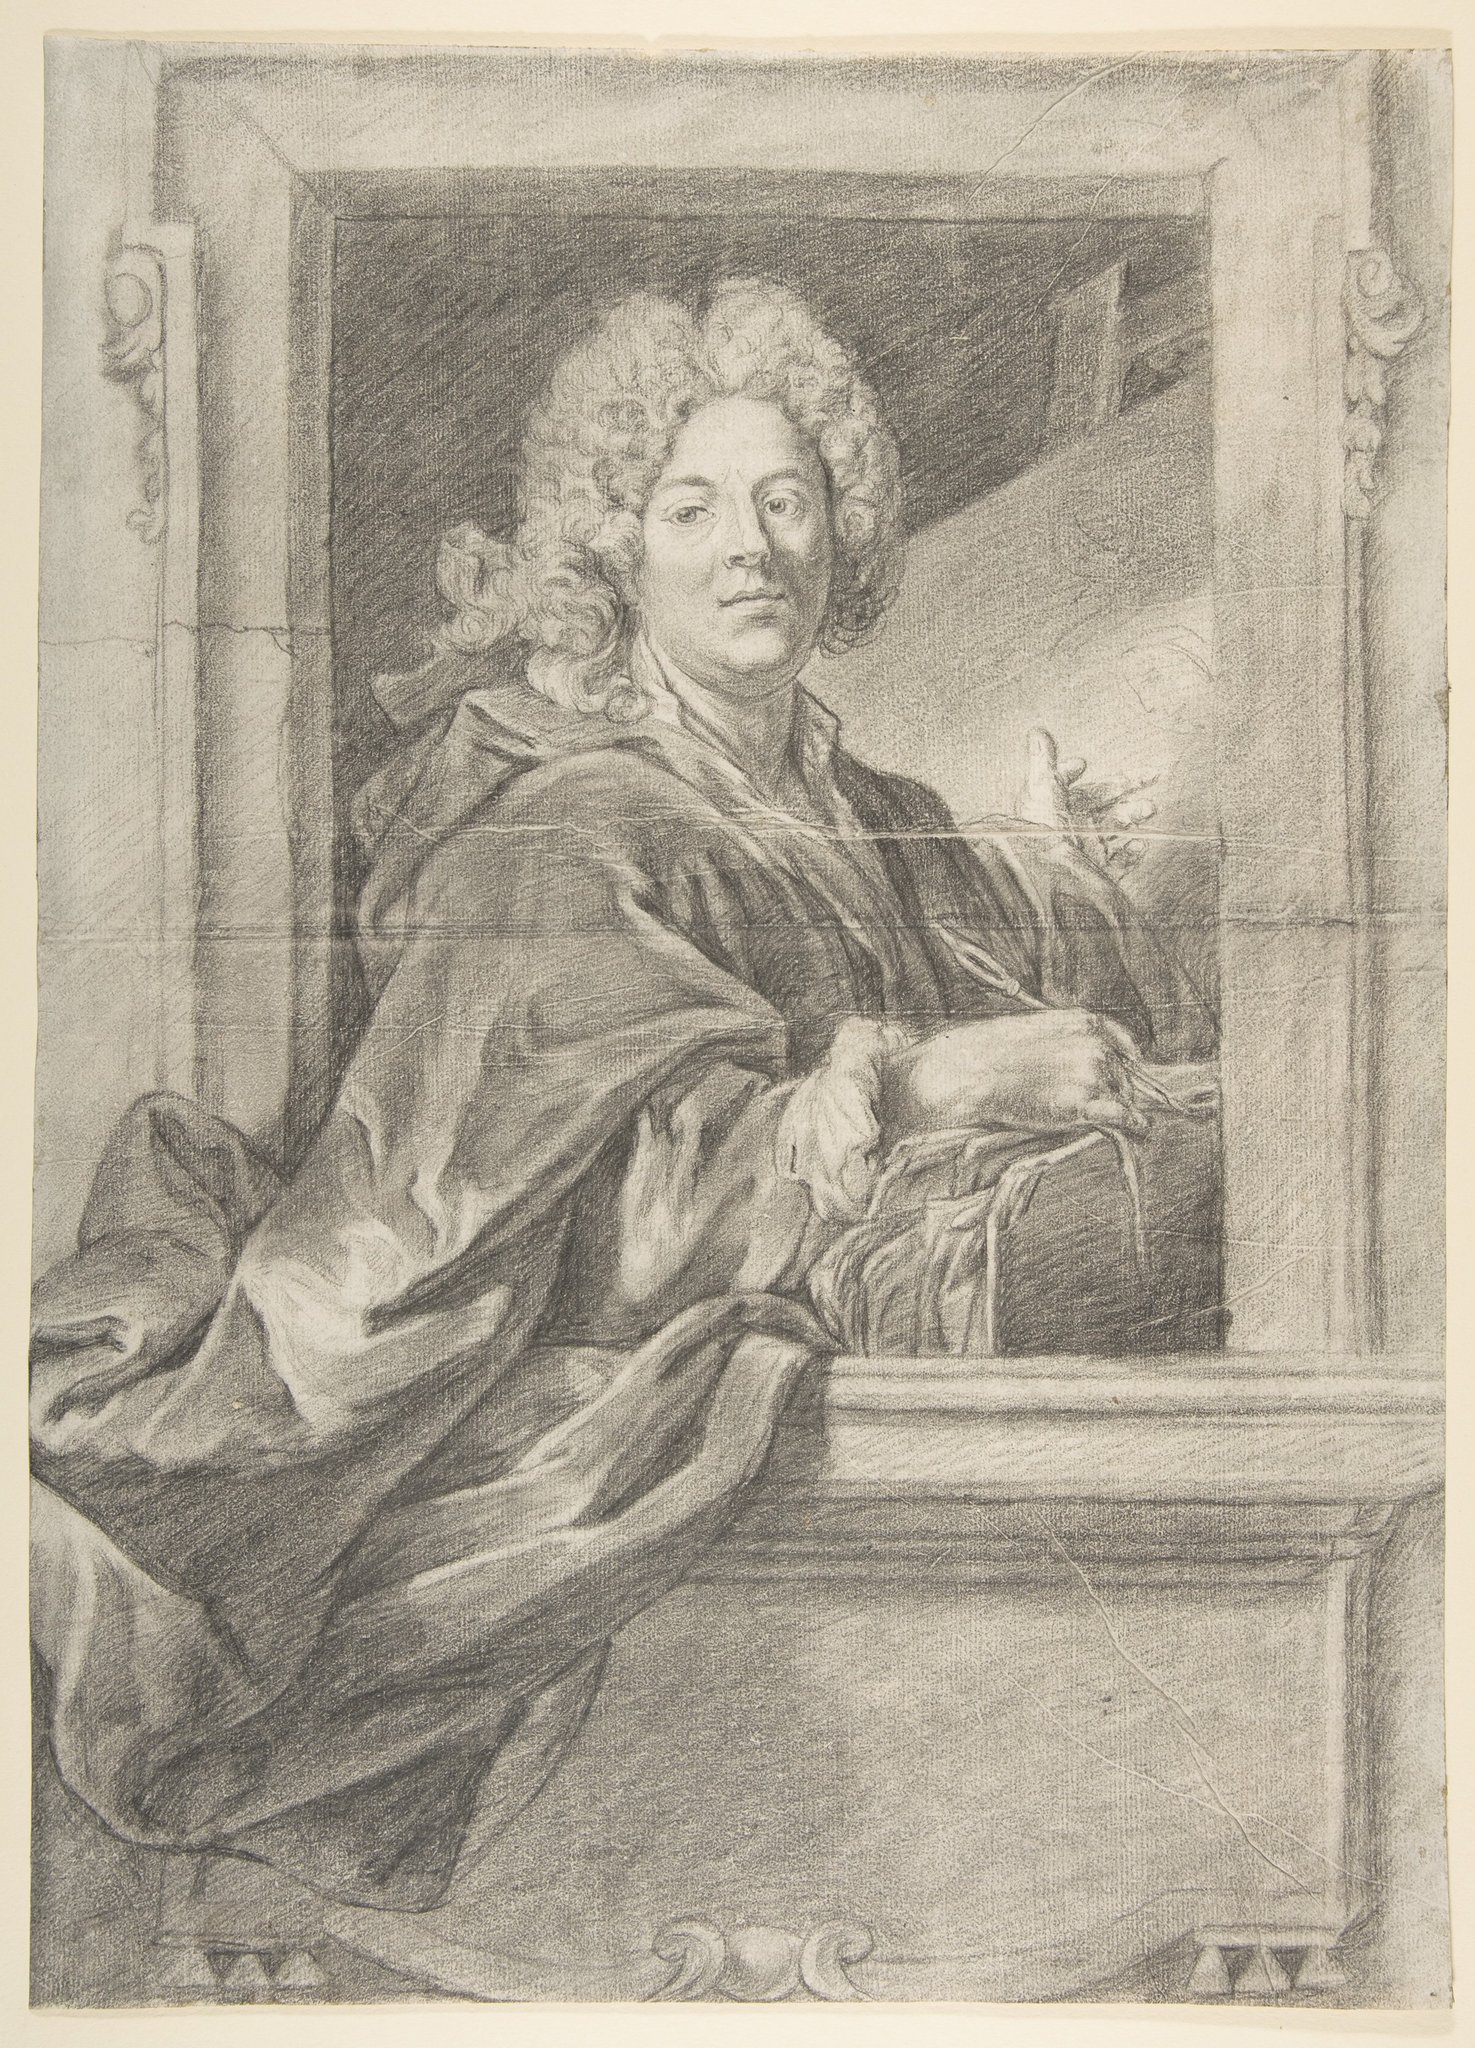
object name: drawing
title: Preparation for Portrait Engraving of Artist in Frame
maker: anonymous, french, 18th century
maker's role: artist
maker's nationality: french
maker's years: 1700-1800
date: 1701-1800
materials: chalk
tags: men,portraits